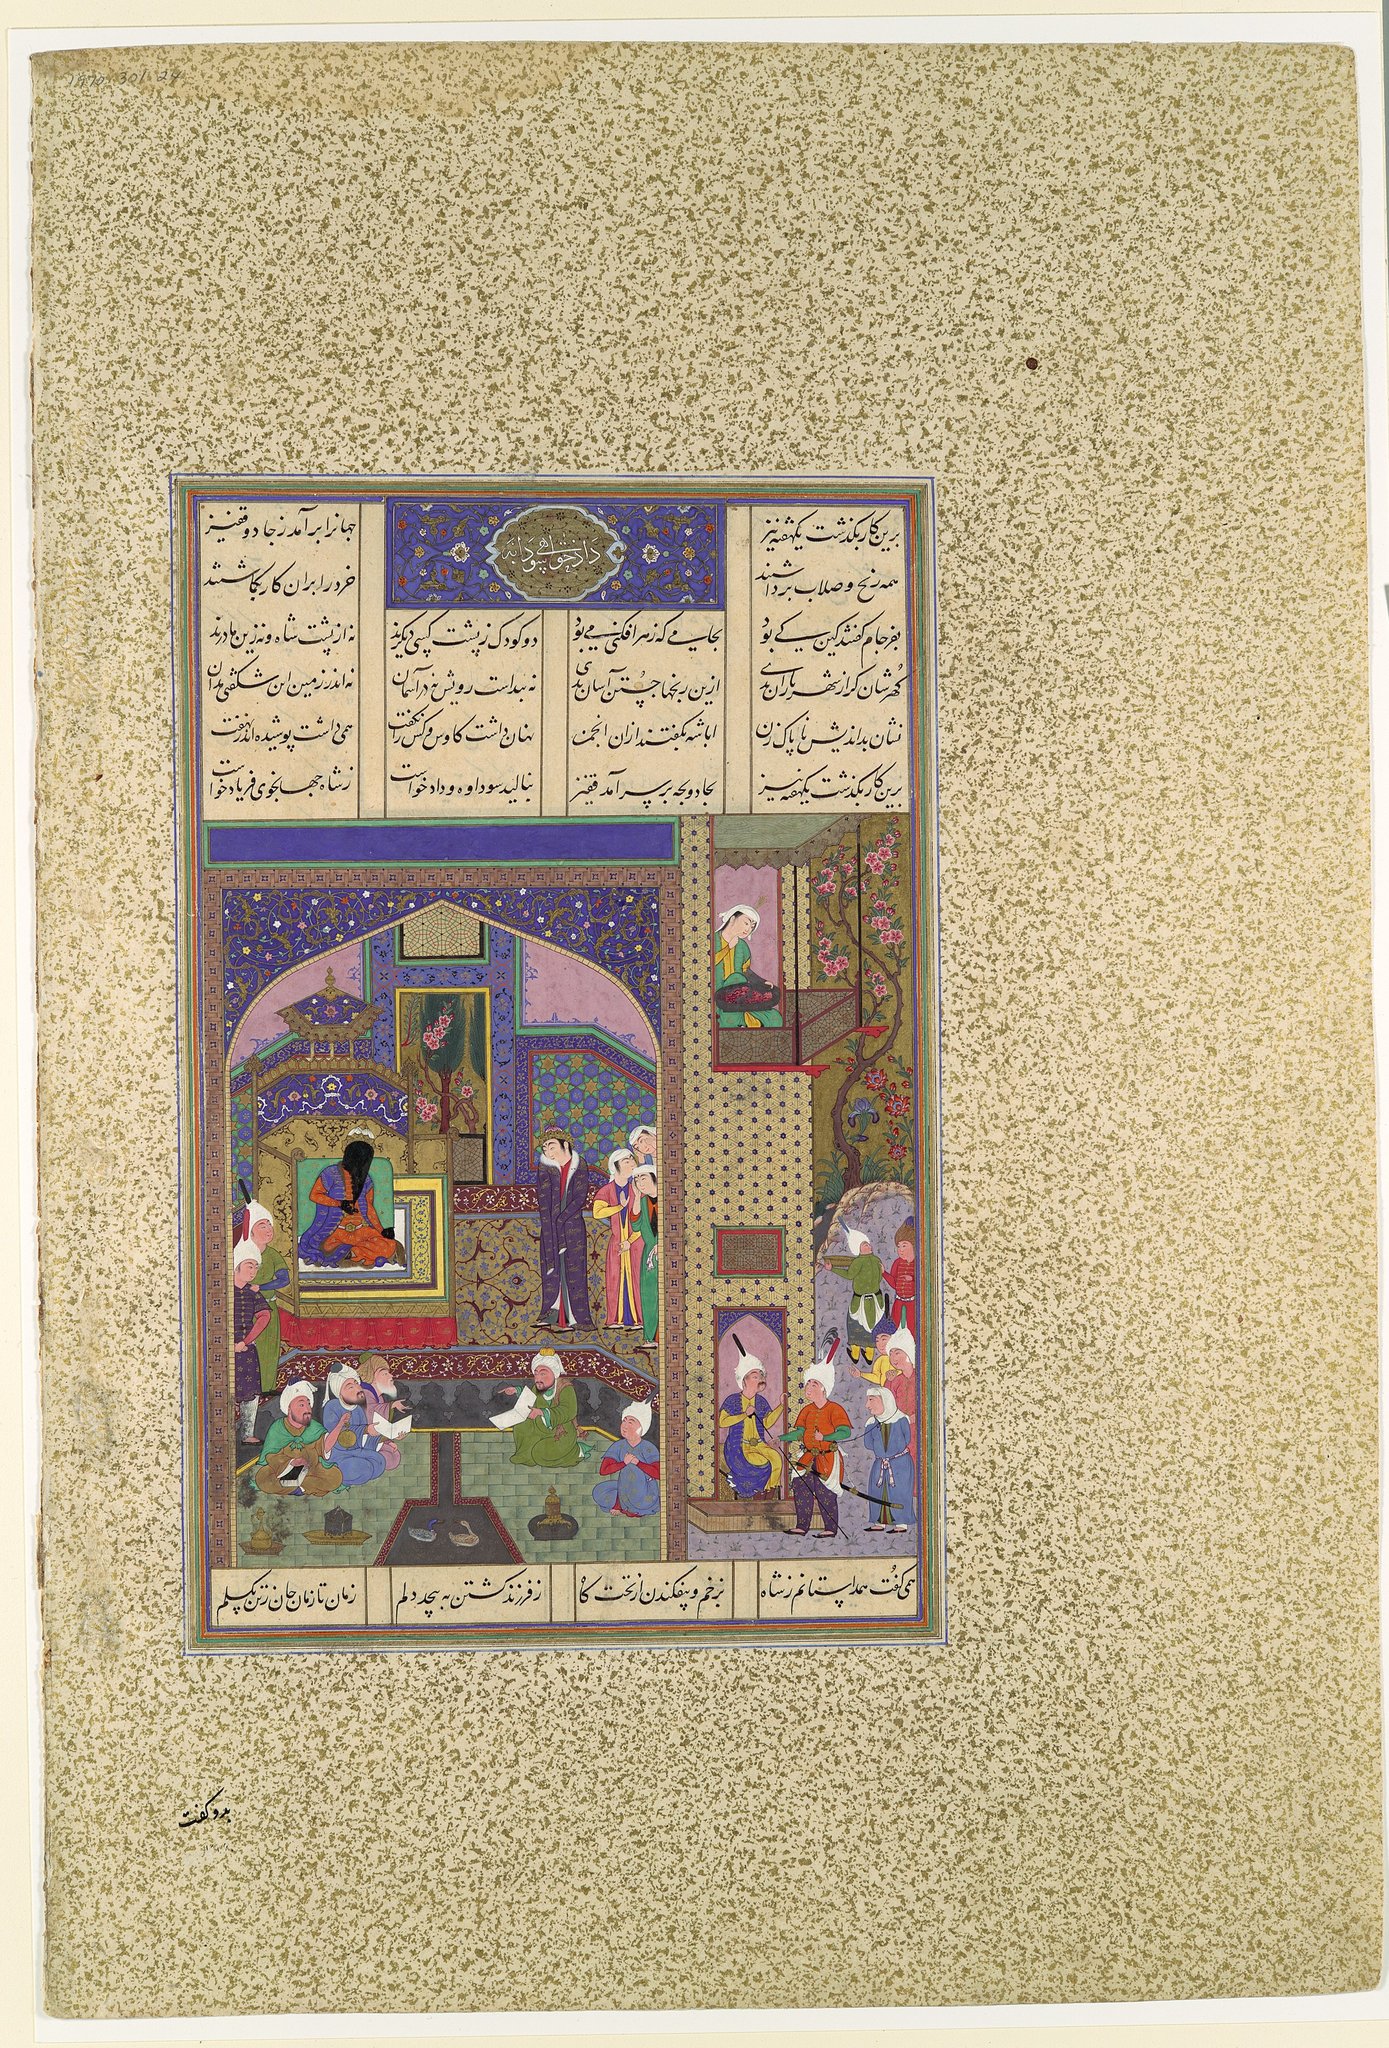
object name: folio from an illustrated manuscript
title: "Sudaba's Second Accusation Against Siyavush is Judged", Folio 164v from the Shahnama (Book of Kings) of Shah Tahmasp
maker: abu'l qasim firdausi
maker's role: author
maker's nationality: iranian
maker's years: 935-1020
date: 1525-1530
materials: gold, ink, paper, silver, watercolor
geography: iran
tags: men